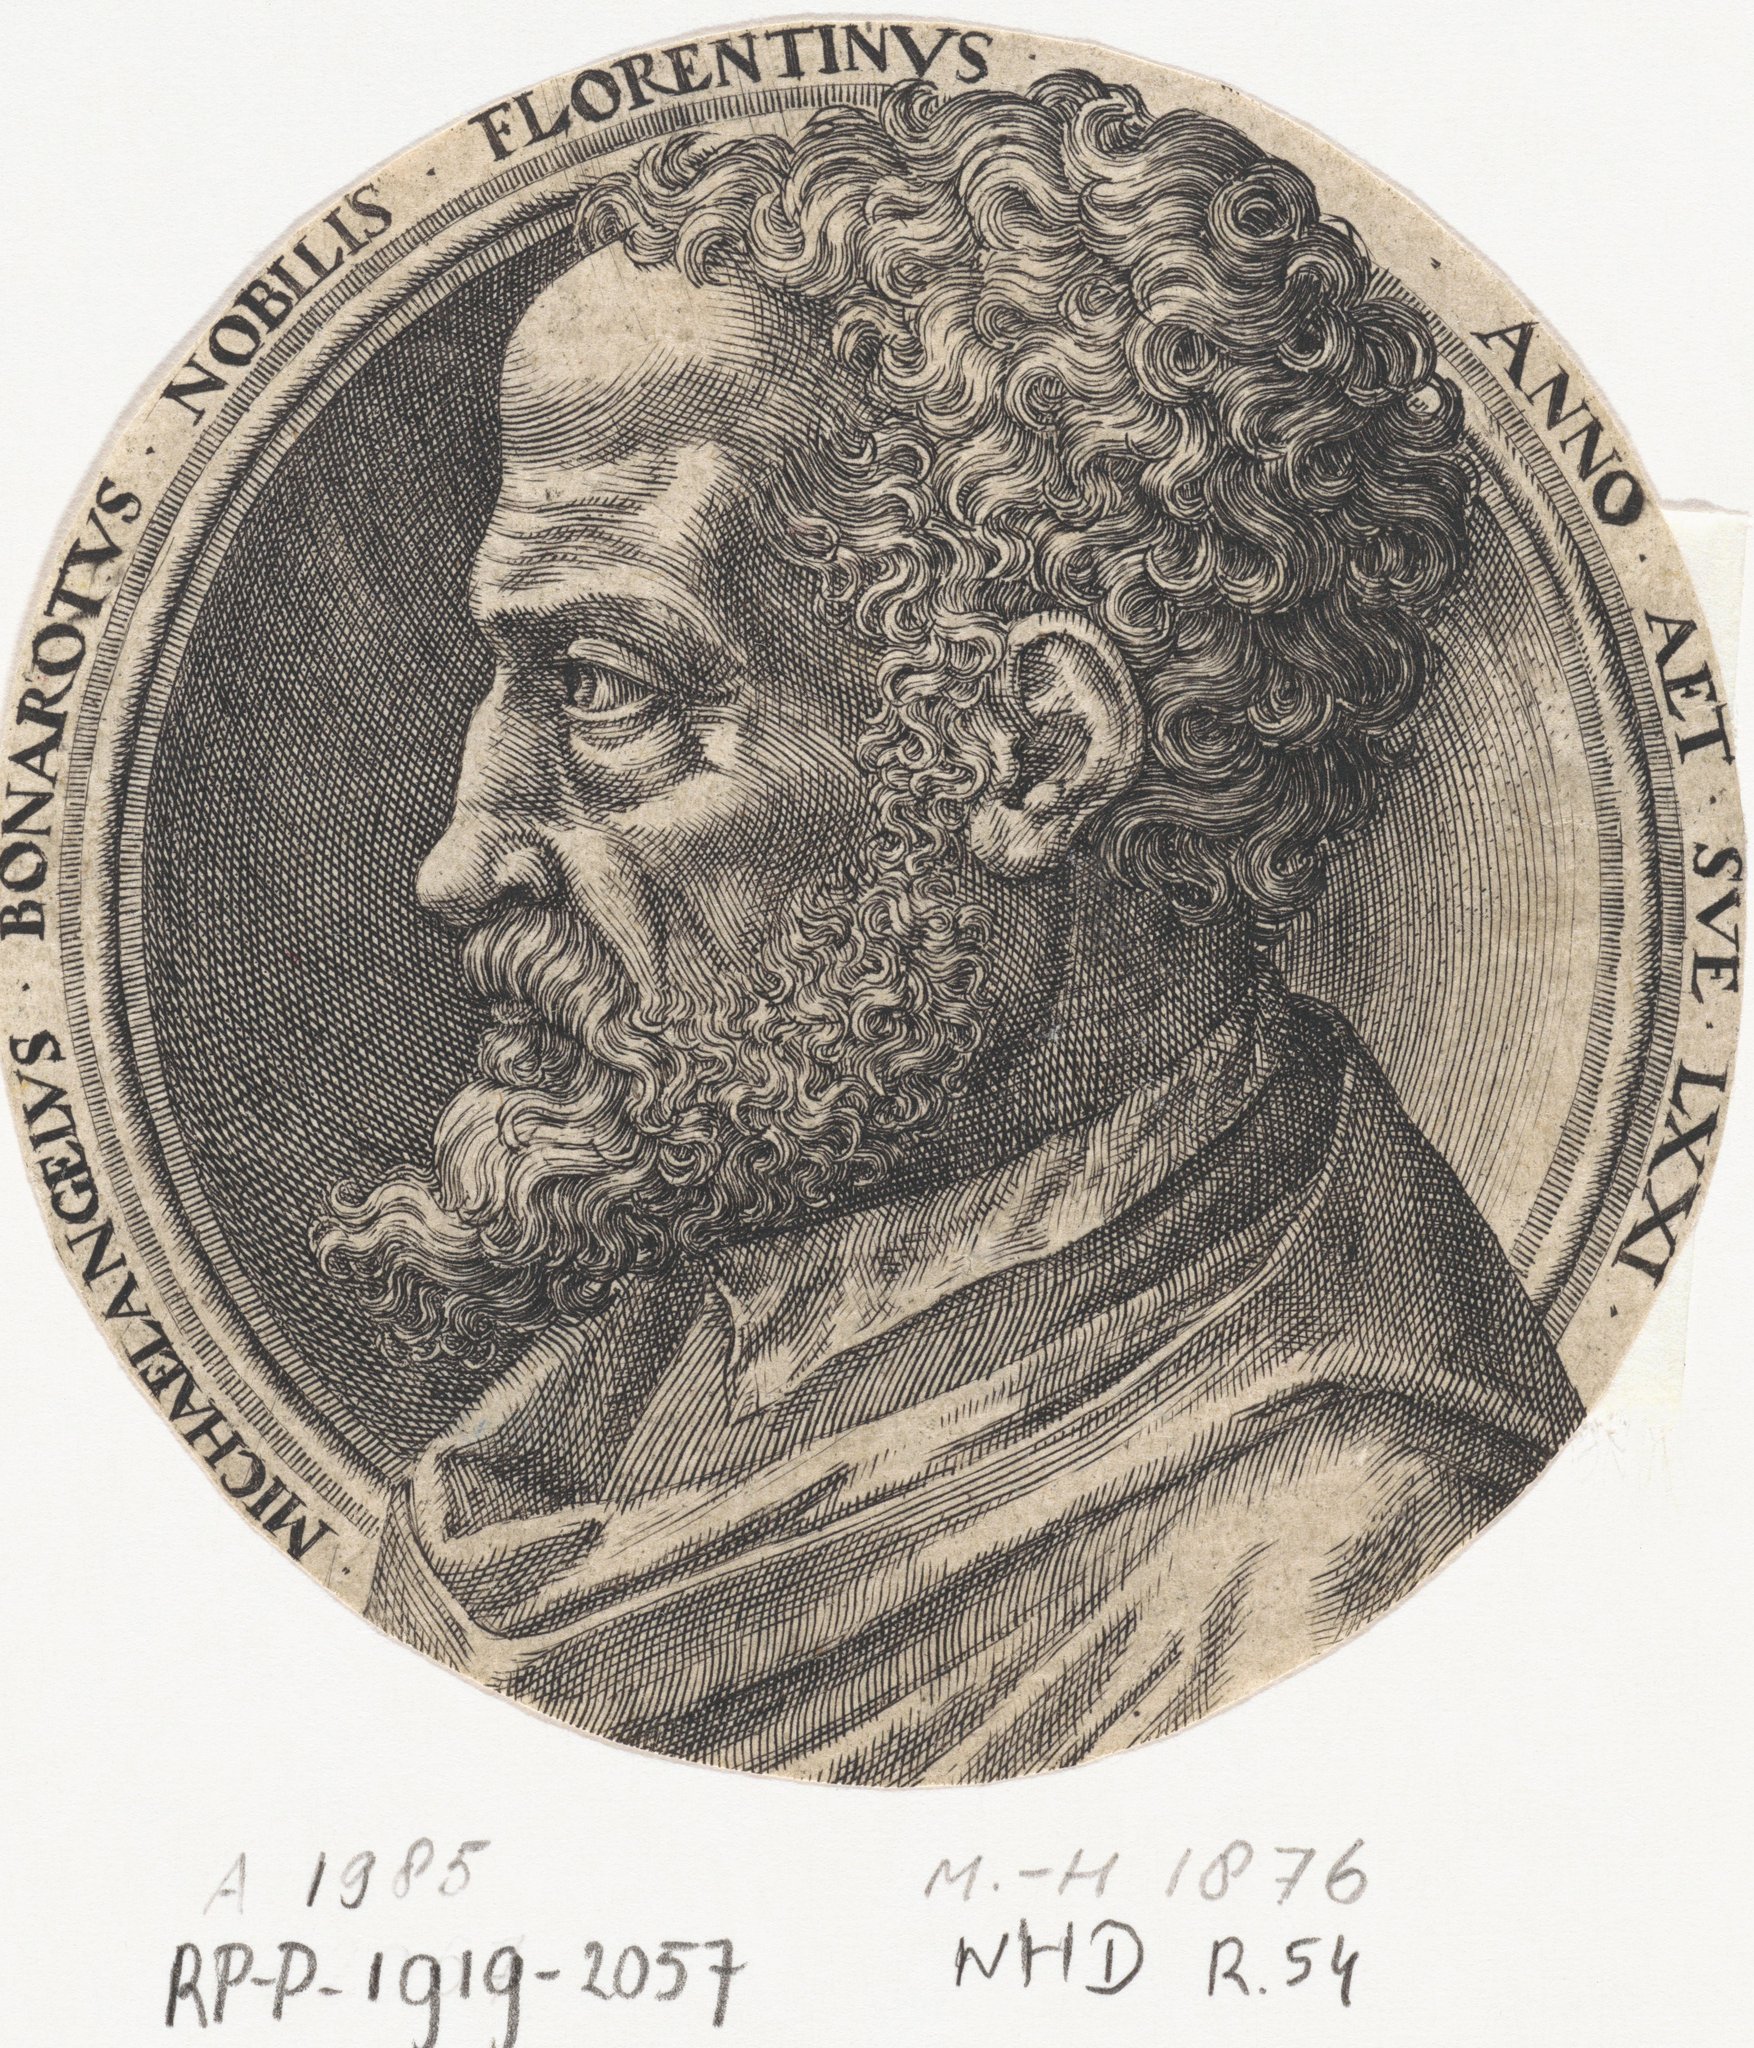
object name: print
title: Portret van de kunstenaar Michelangelo, op 71-jarige leeftijd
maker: Anonymous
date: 1550-1600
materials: paper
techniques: engraving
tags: rome, painter, draughtsman, sculptor, michelangelo, portrait, self-portrait of artist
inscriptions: inscription, collector's mark: Lugt 567, collector's mark: Lugt 2233